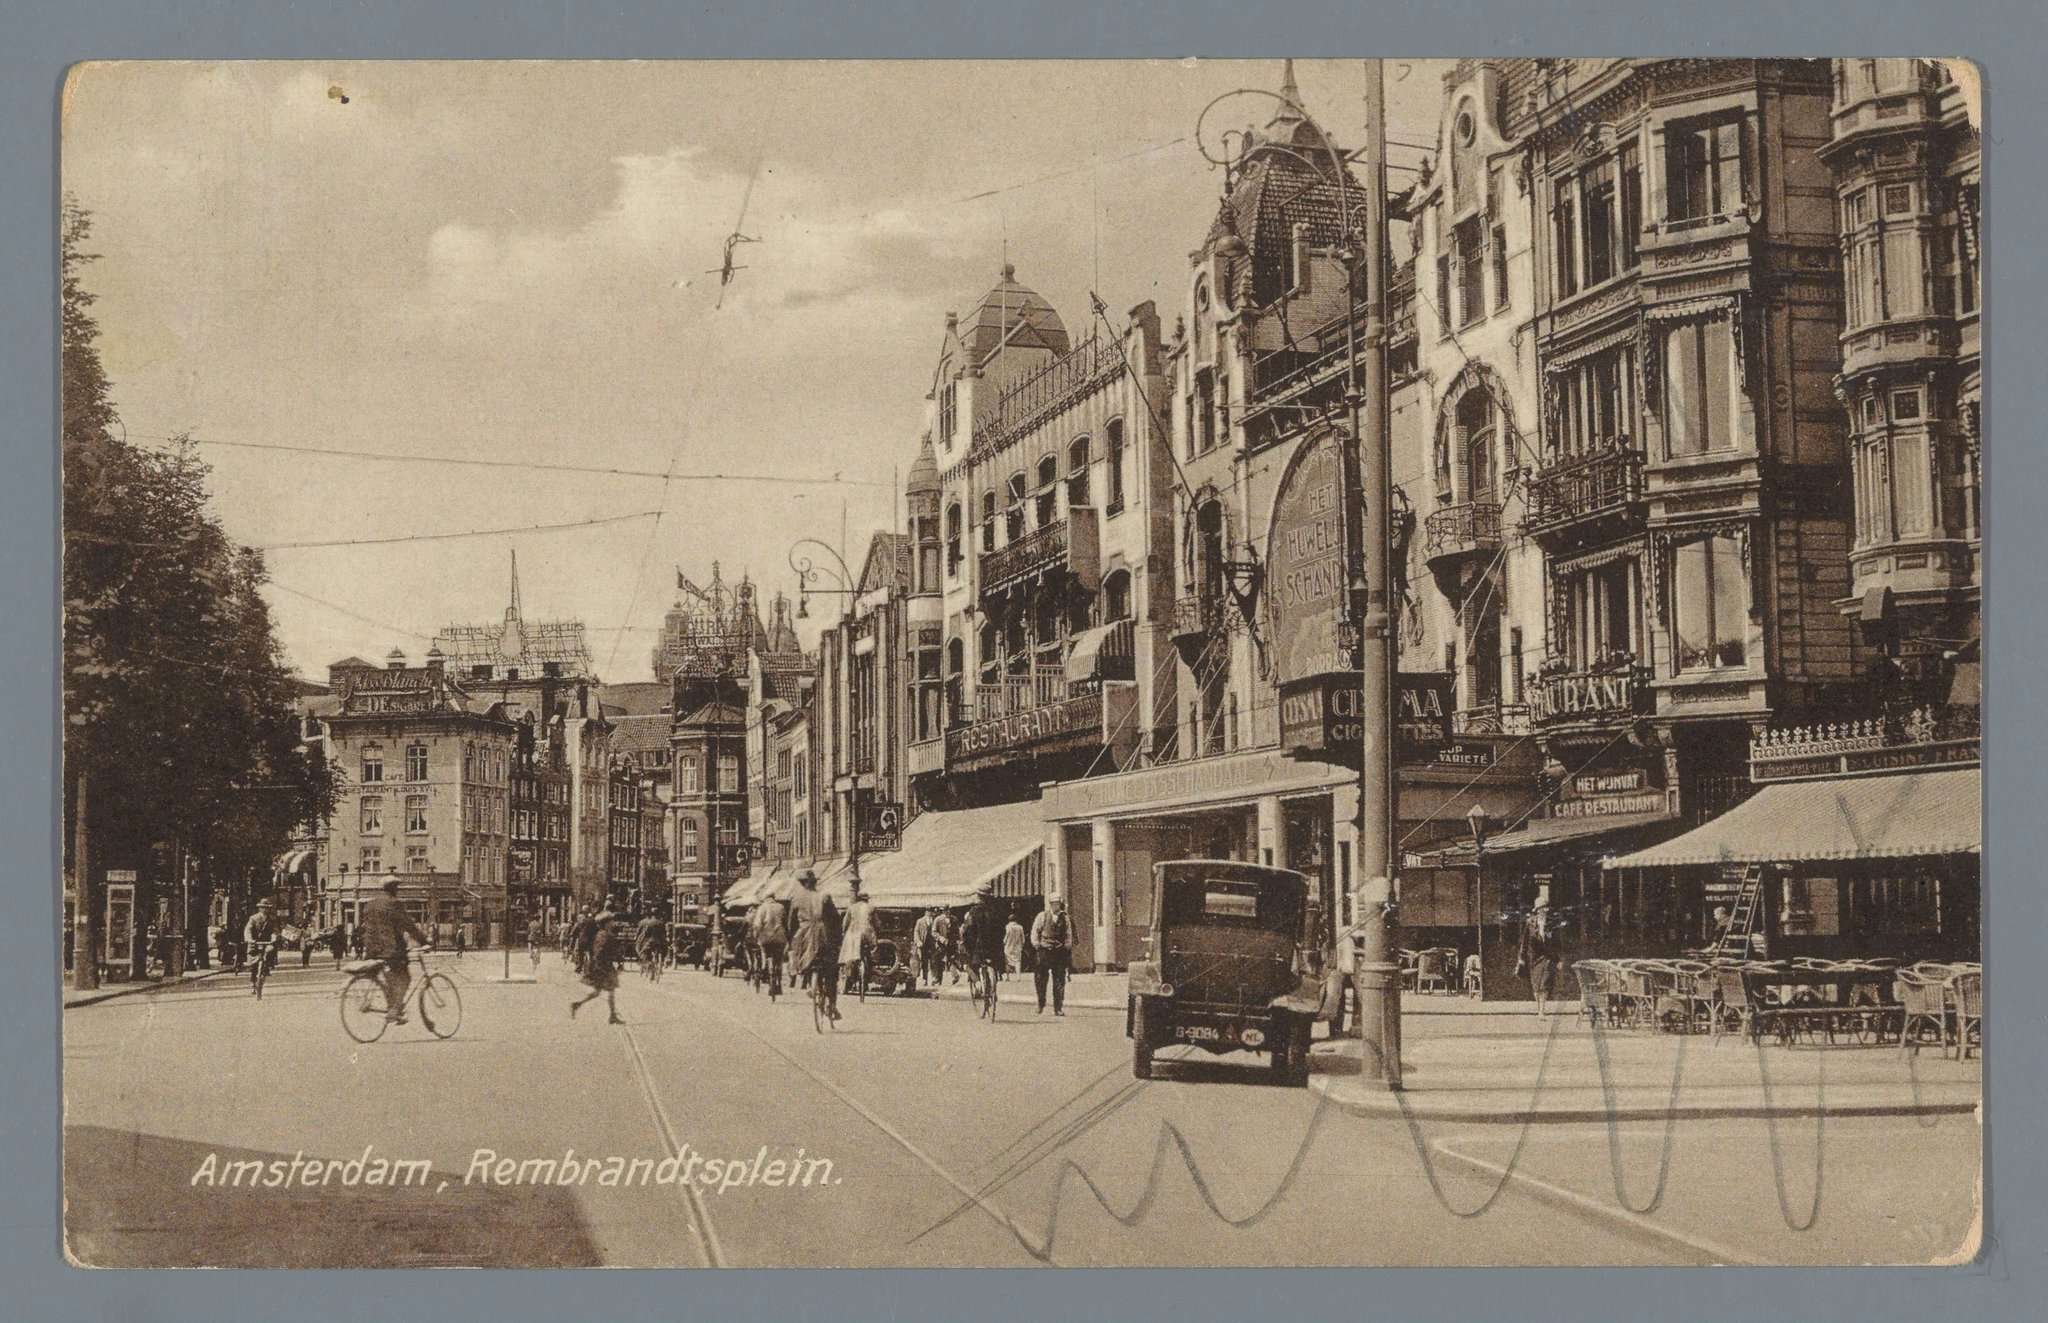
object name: photomechanical print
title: Amsterdam, Rembrandtsplein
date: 1875-1930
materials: cardboard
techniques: photograph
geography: amsterdam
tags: square, place, circus, etc.